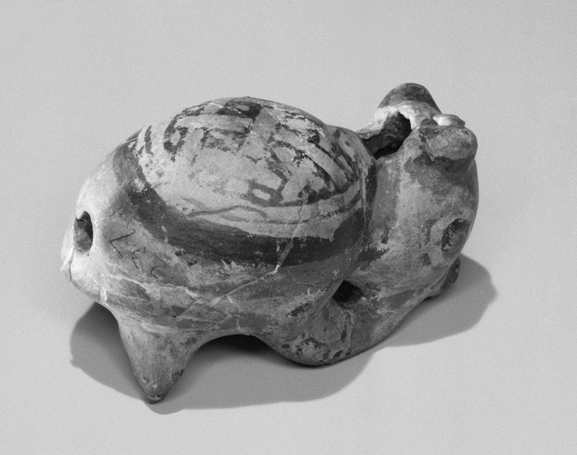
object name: pottery whistle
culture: costa rican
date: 800-1525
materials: clay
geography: costa rica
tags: animals